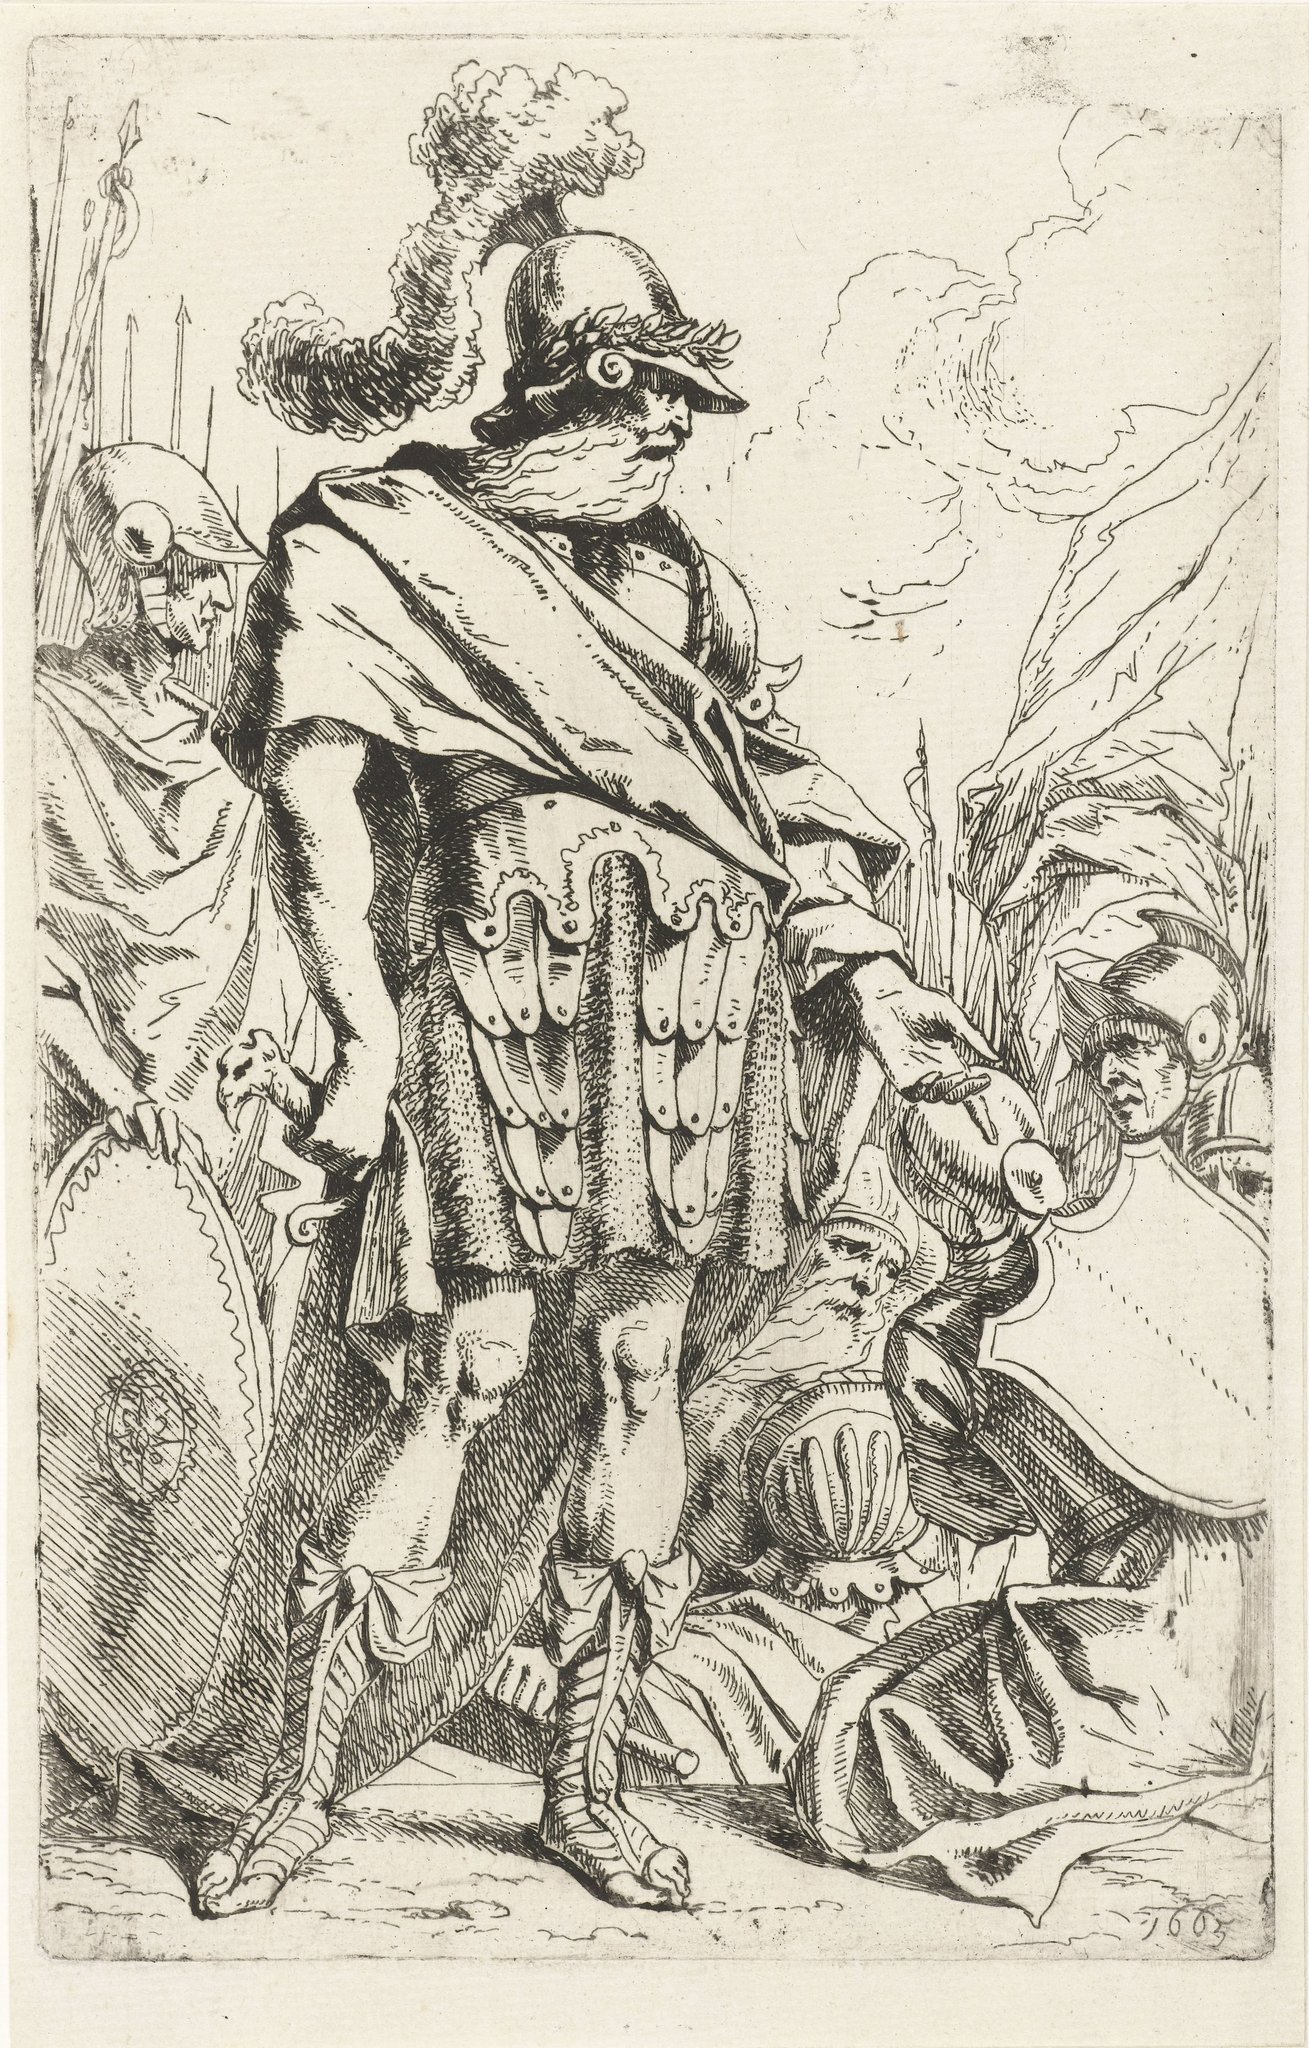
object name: print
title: Romeinse soldaat met helm en baard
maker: leendert van der cooghen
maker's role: draughtsman, print maker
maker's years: 1632-1681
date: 1665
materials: paper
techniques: etching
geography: haarlem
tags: scholastic education, tuition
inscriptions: collector's mark: Lugt 240